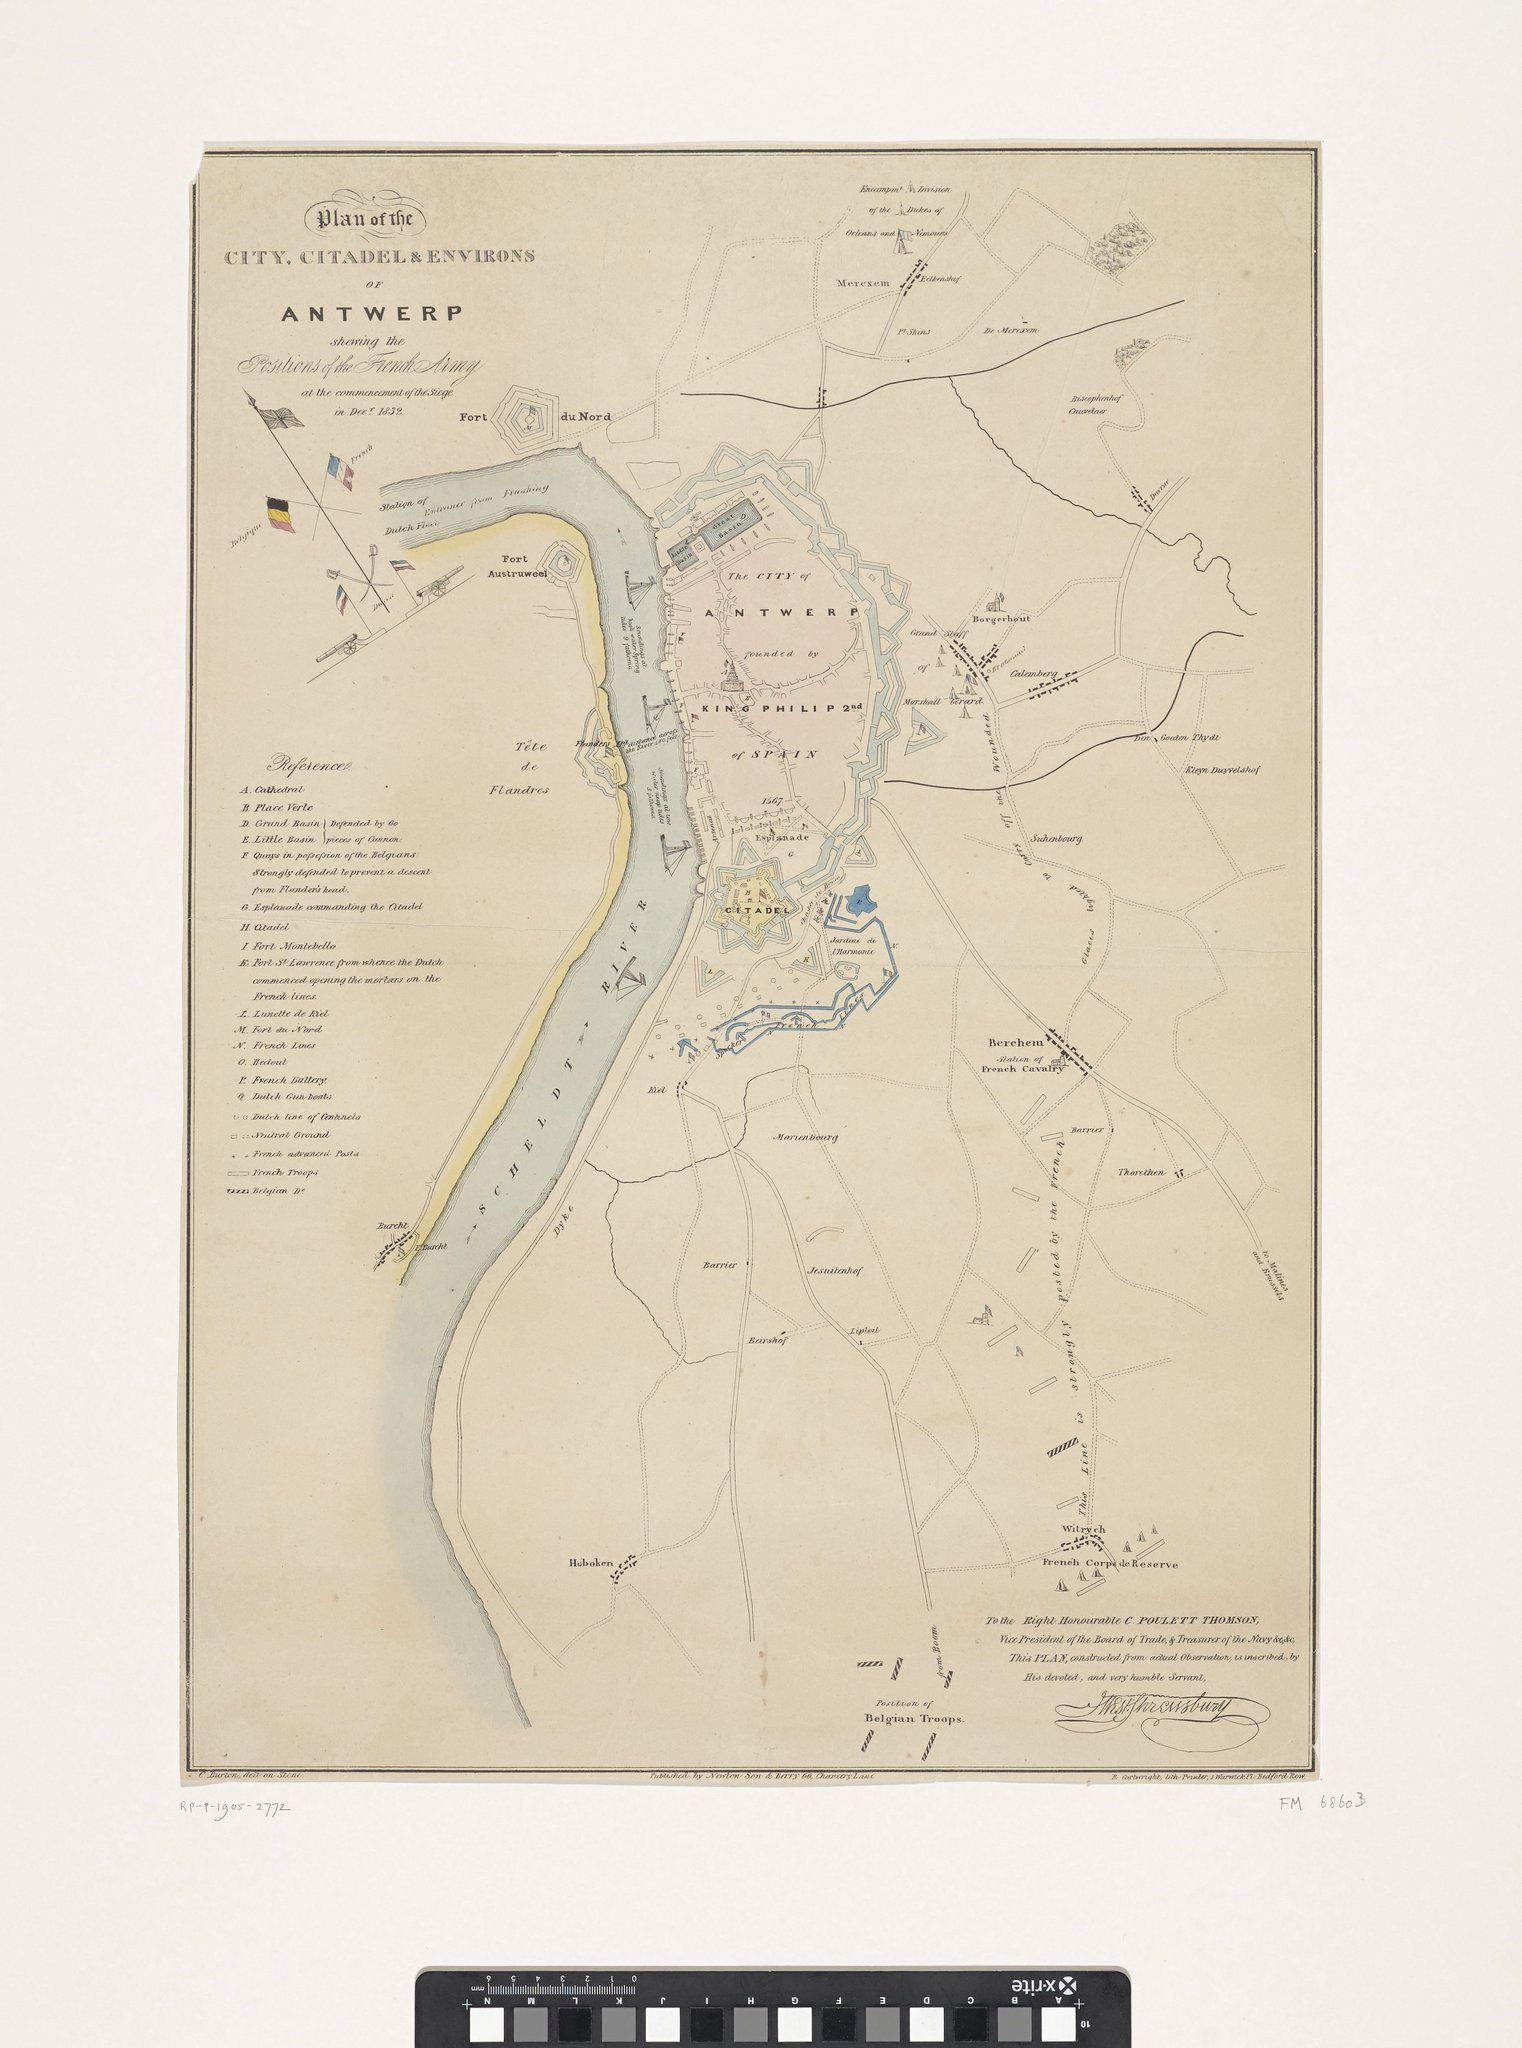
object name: print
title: Plan of the City, Citadel & Environs of Antwerp shewing the Positions of the French Army at the commencement of the siege in Dec.r 1832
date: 1832-1833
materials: paper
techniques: hand coloring, lithograph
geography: london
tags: fortress, plan ~ architecture, maps of cities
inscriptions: collector's mark: Lugt 2228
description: Plattegrond van Antwerpen en omgeving met de Citadel, waarop is aangegeven de ligging van het Franse leger bij de aanvang van het beleg in december 1832. Links de legenda A-Q. Engelse kaart met Engelse opschriften.